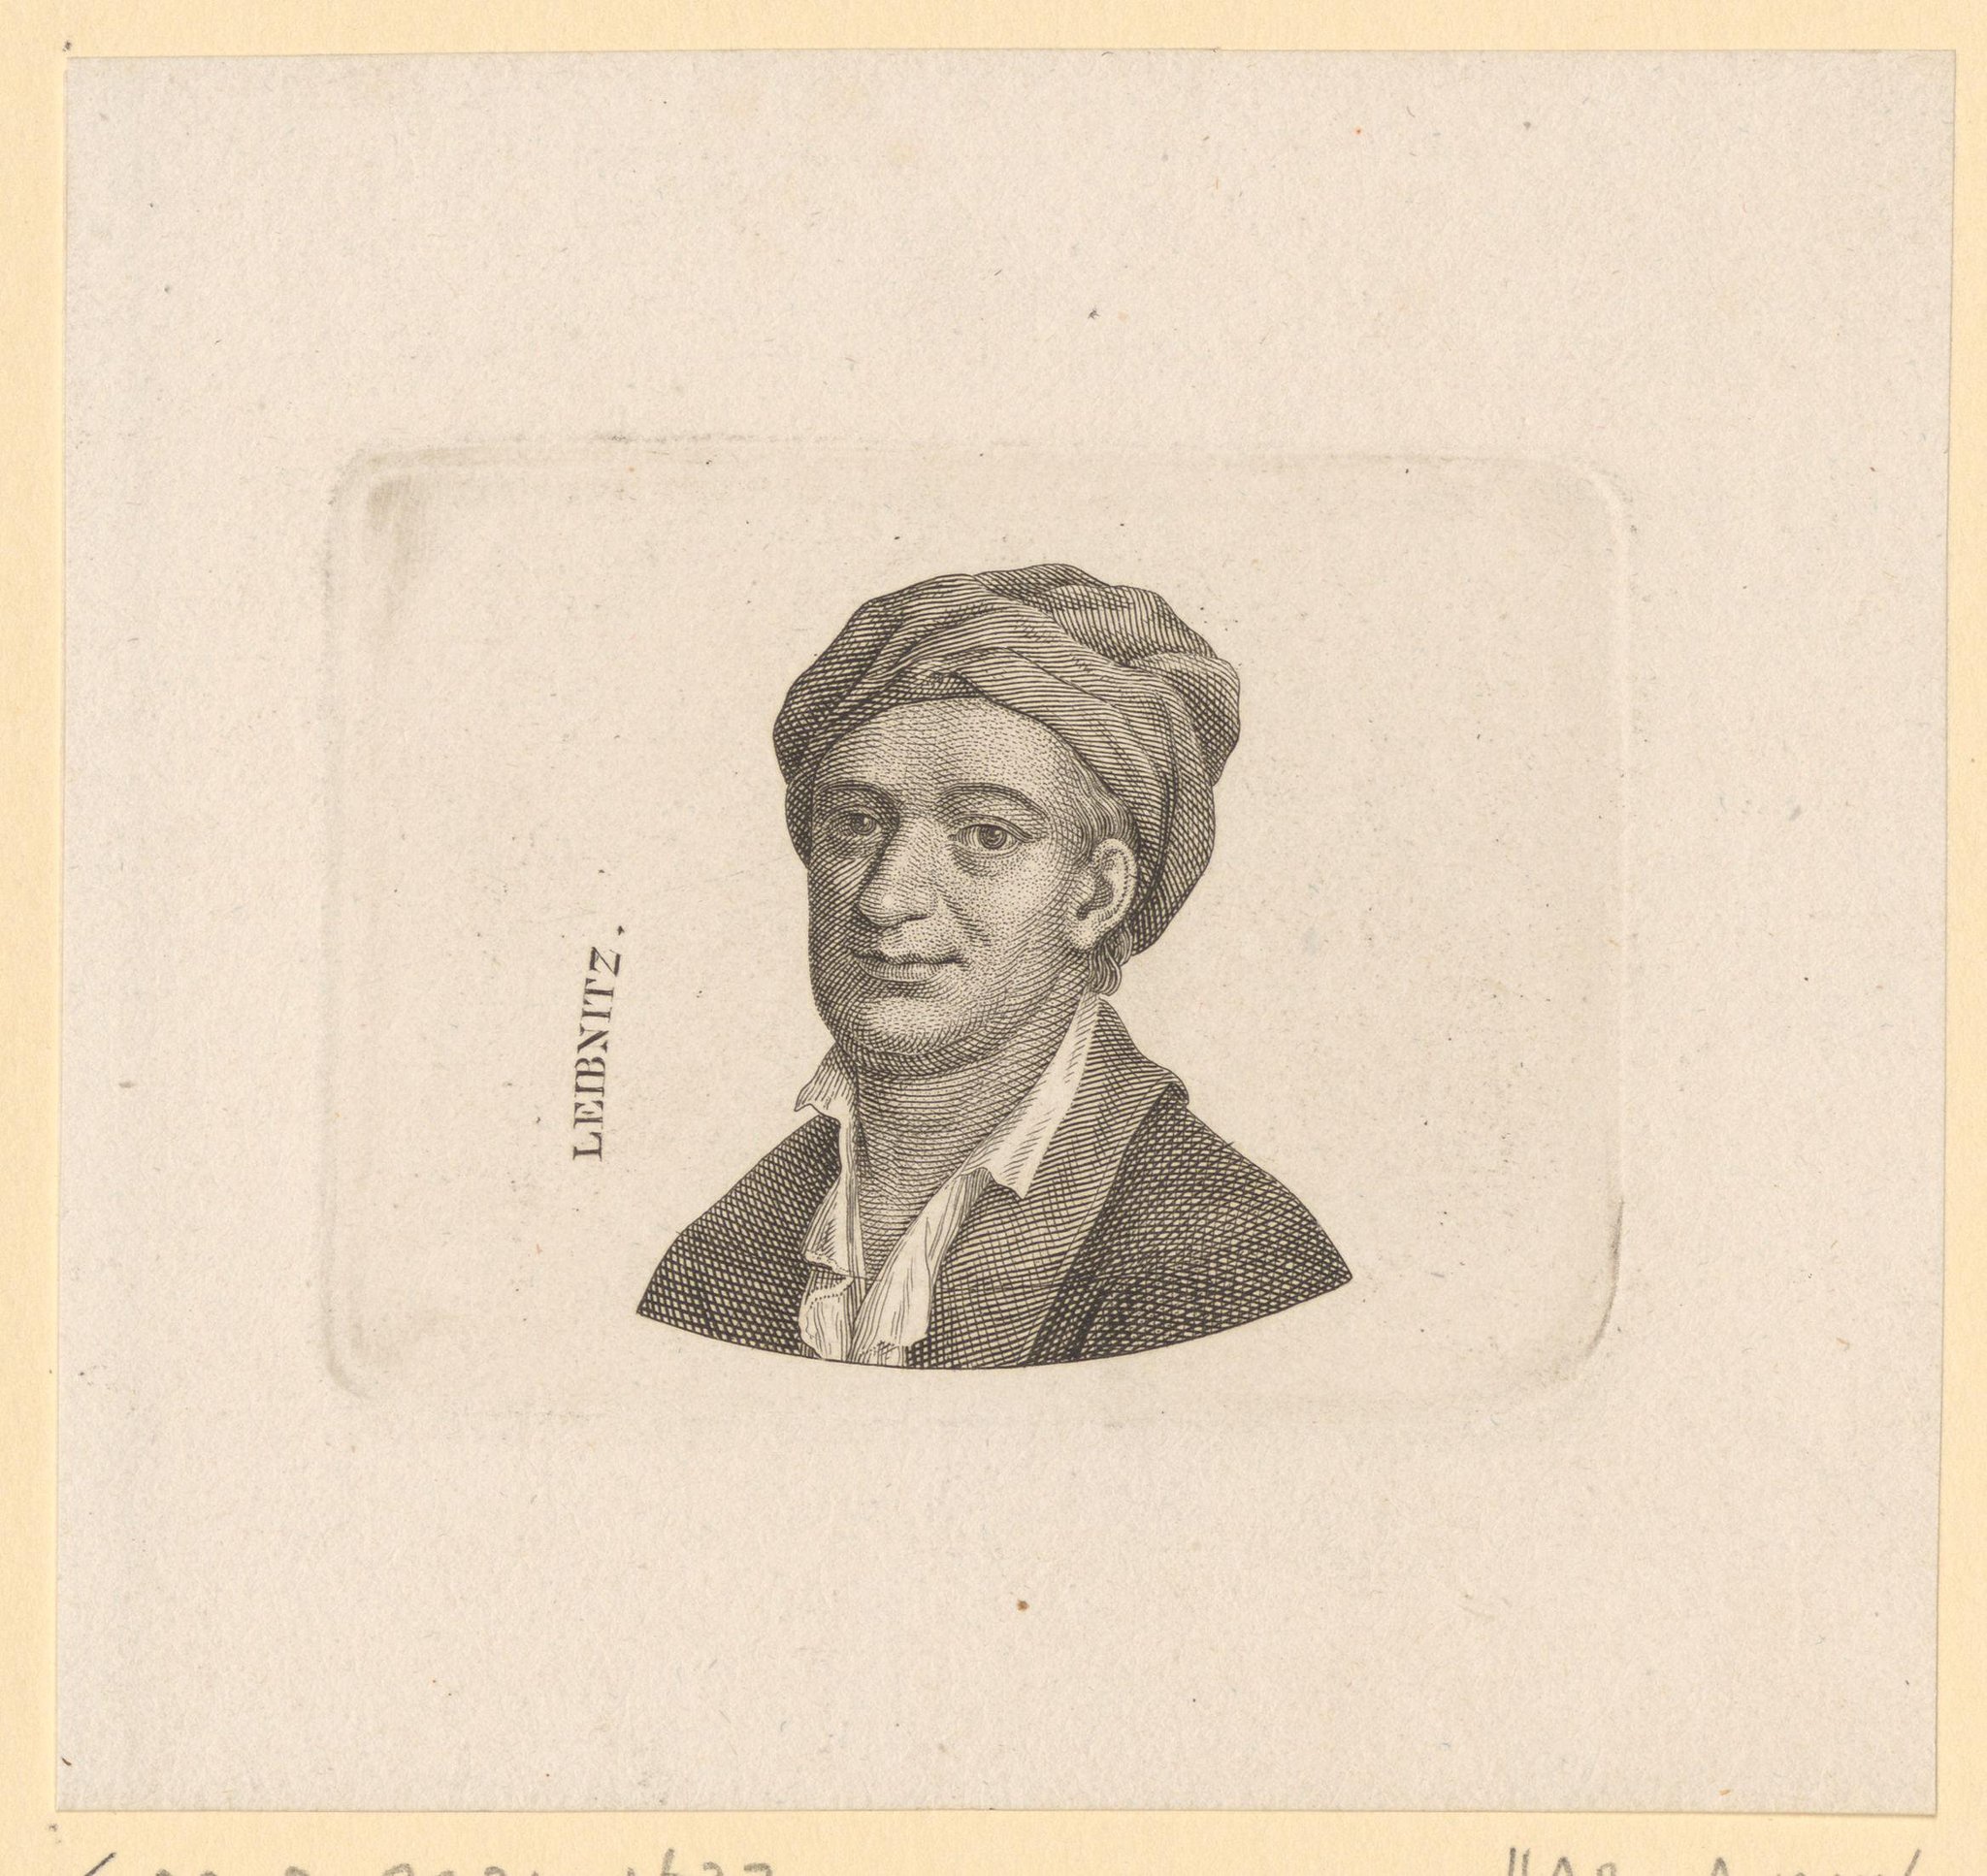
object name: print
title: Portret van Gottfried Wilhelm Leibniz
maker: ernst ludwig riepenhausen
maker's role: print maker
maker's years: 1765-1840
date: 1775-1840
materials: paper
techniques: etching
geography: germany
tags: historical persons, scholar, philosopher (+ portrait of scholar, scientist)